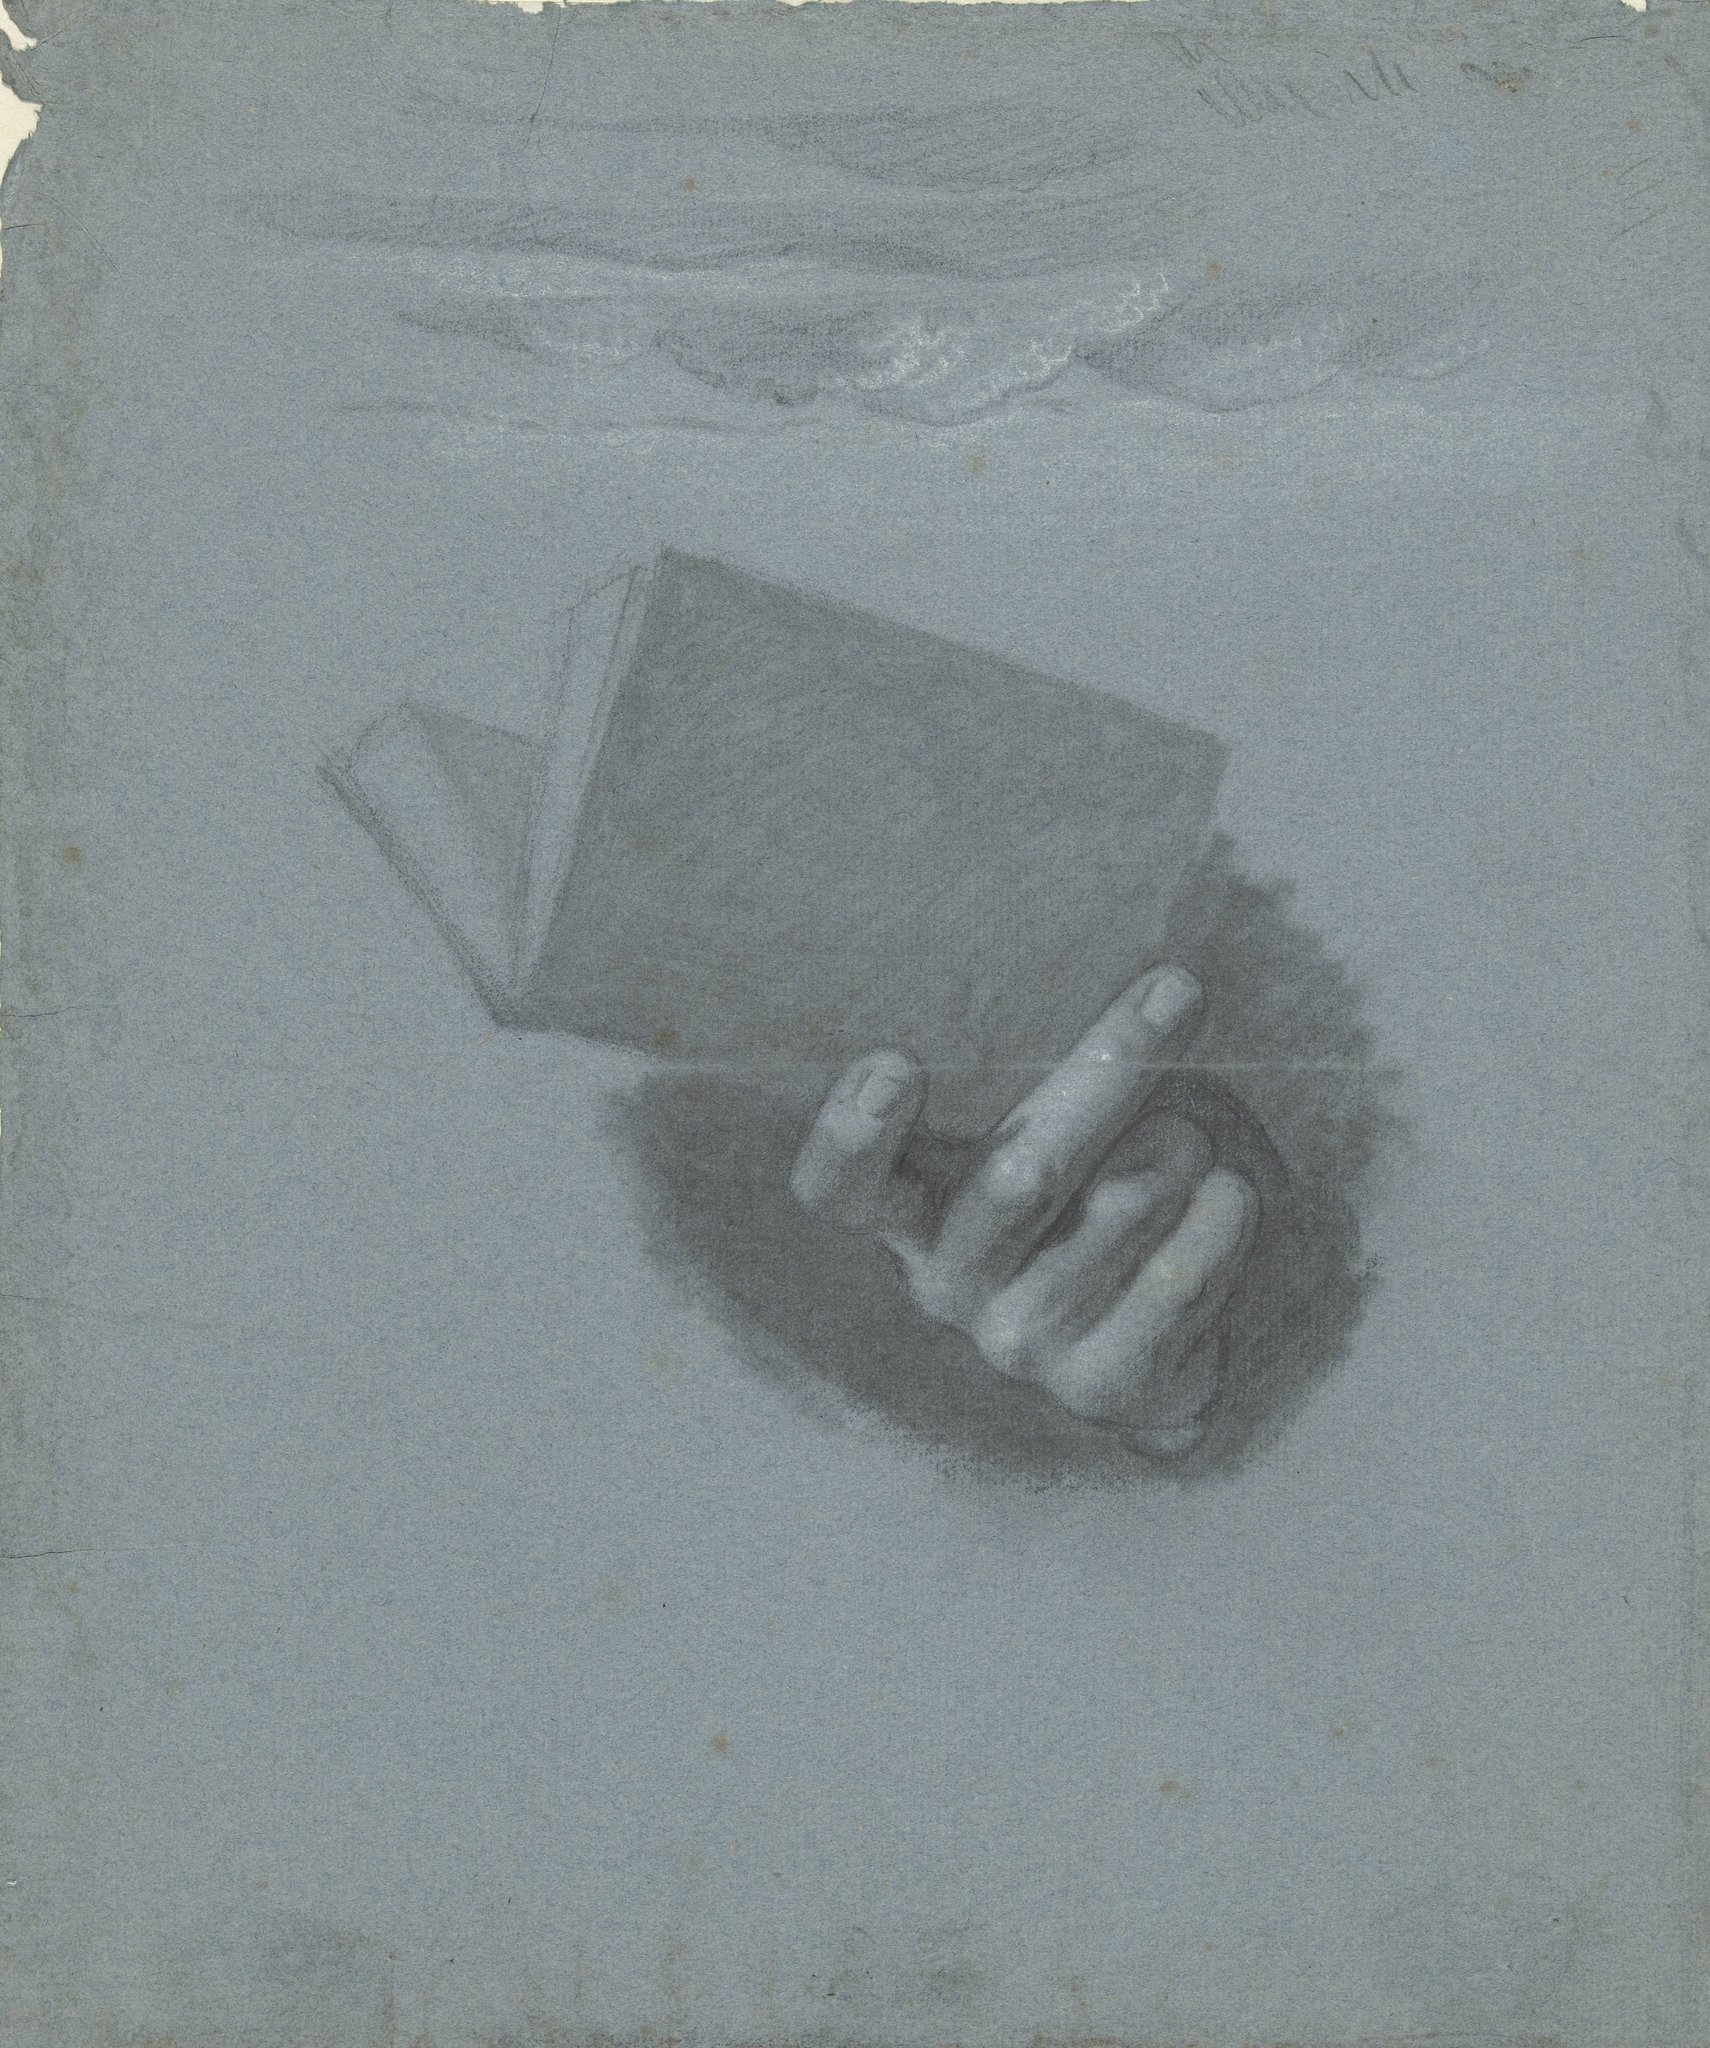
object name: drawing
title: Studie van een hand die een boek vasthoudt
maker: charles howard hodges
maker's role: draughtsman, painter, print maker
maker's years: 1764-1837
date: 1774-1837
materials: chalk, paper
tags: hand